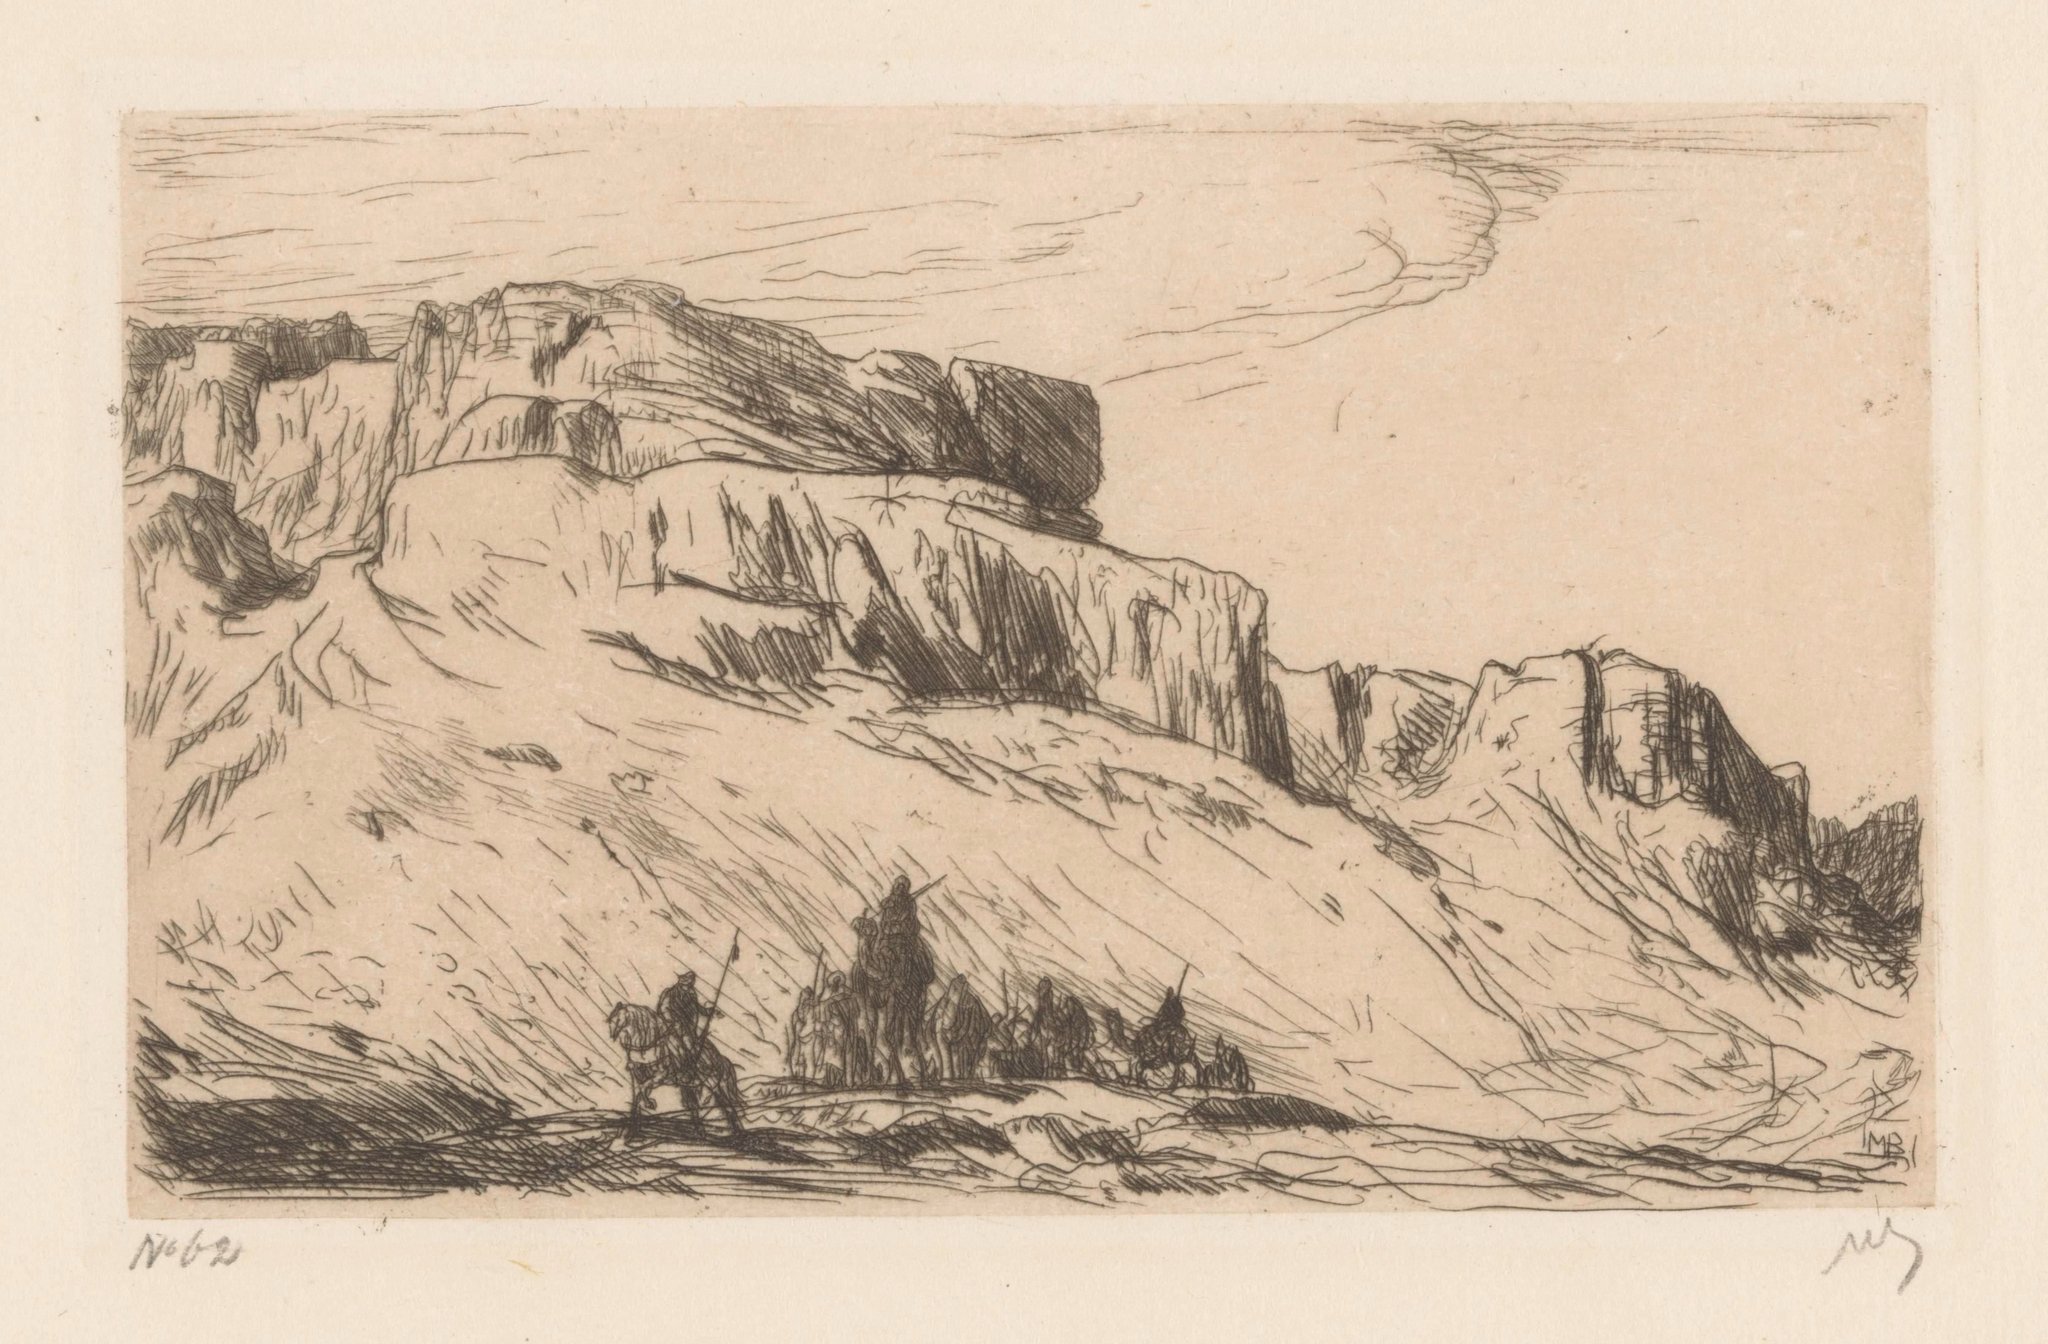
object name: print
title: Karavaan met kamelen in woestijnlandschap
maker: marius bauer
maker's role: draughtsman, print maker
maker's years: 1867-1932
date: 1900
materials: paper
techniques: etching, intaglio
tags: riding a horse, ass, or mule; rider, horseman, hoofed animals: camel, desert - kk - ideal landscapes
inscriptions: collector's mark: Lugt 2228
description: Een ruiter op een paard gaat een karavaan met ruiters op kamelen voor in een rotsachtig woestijnlandschap.